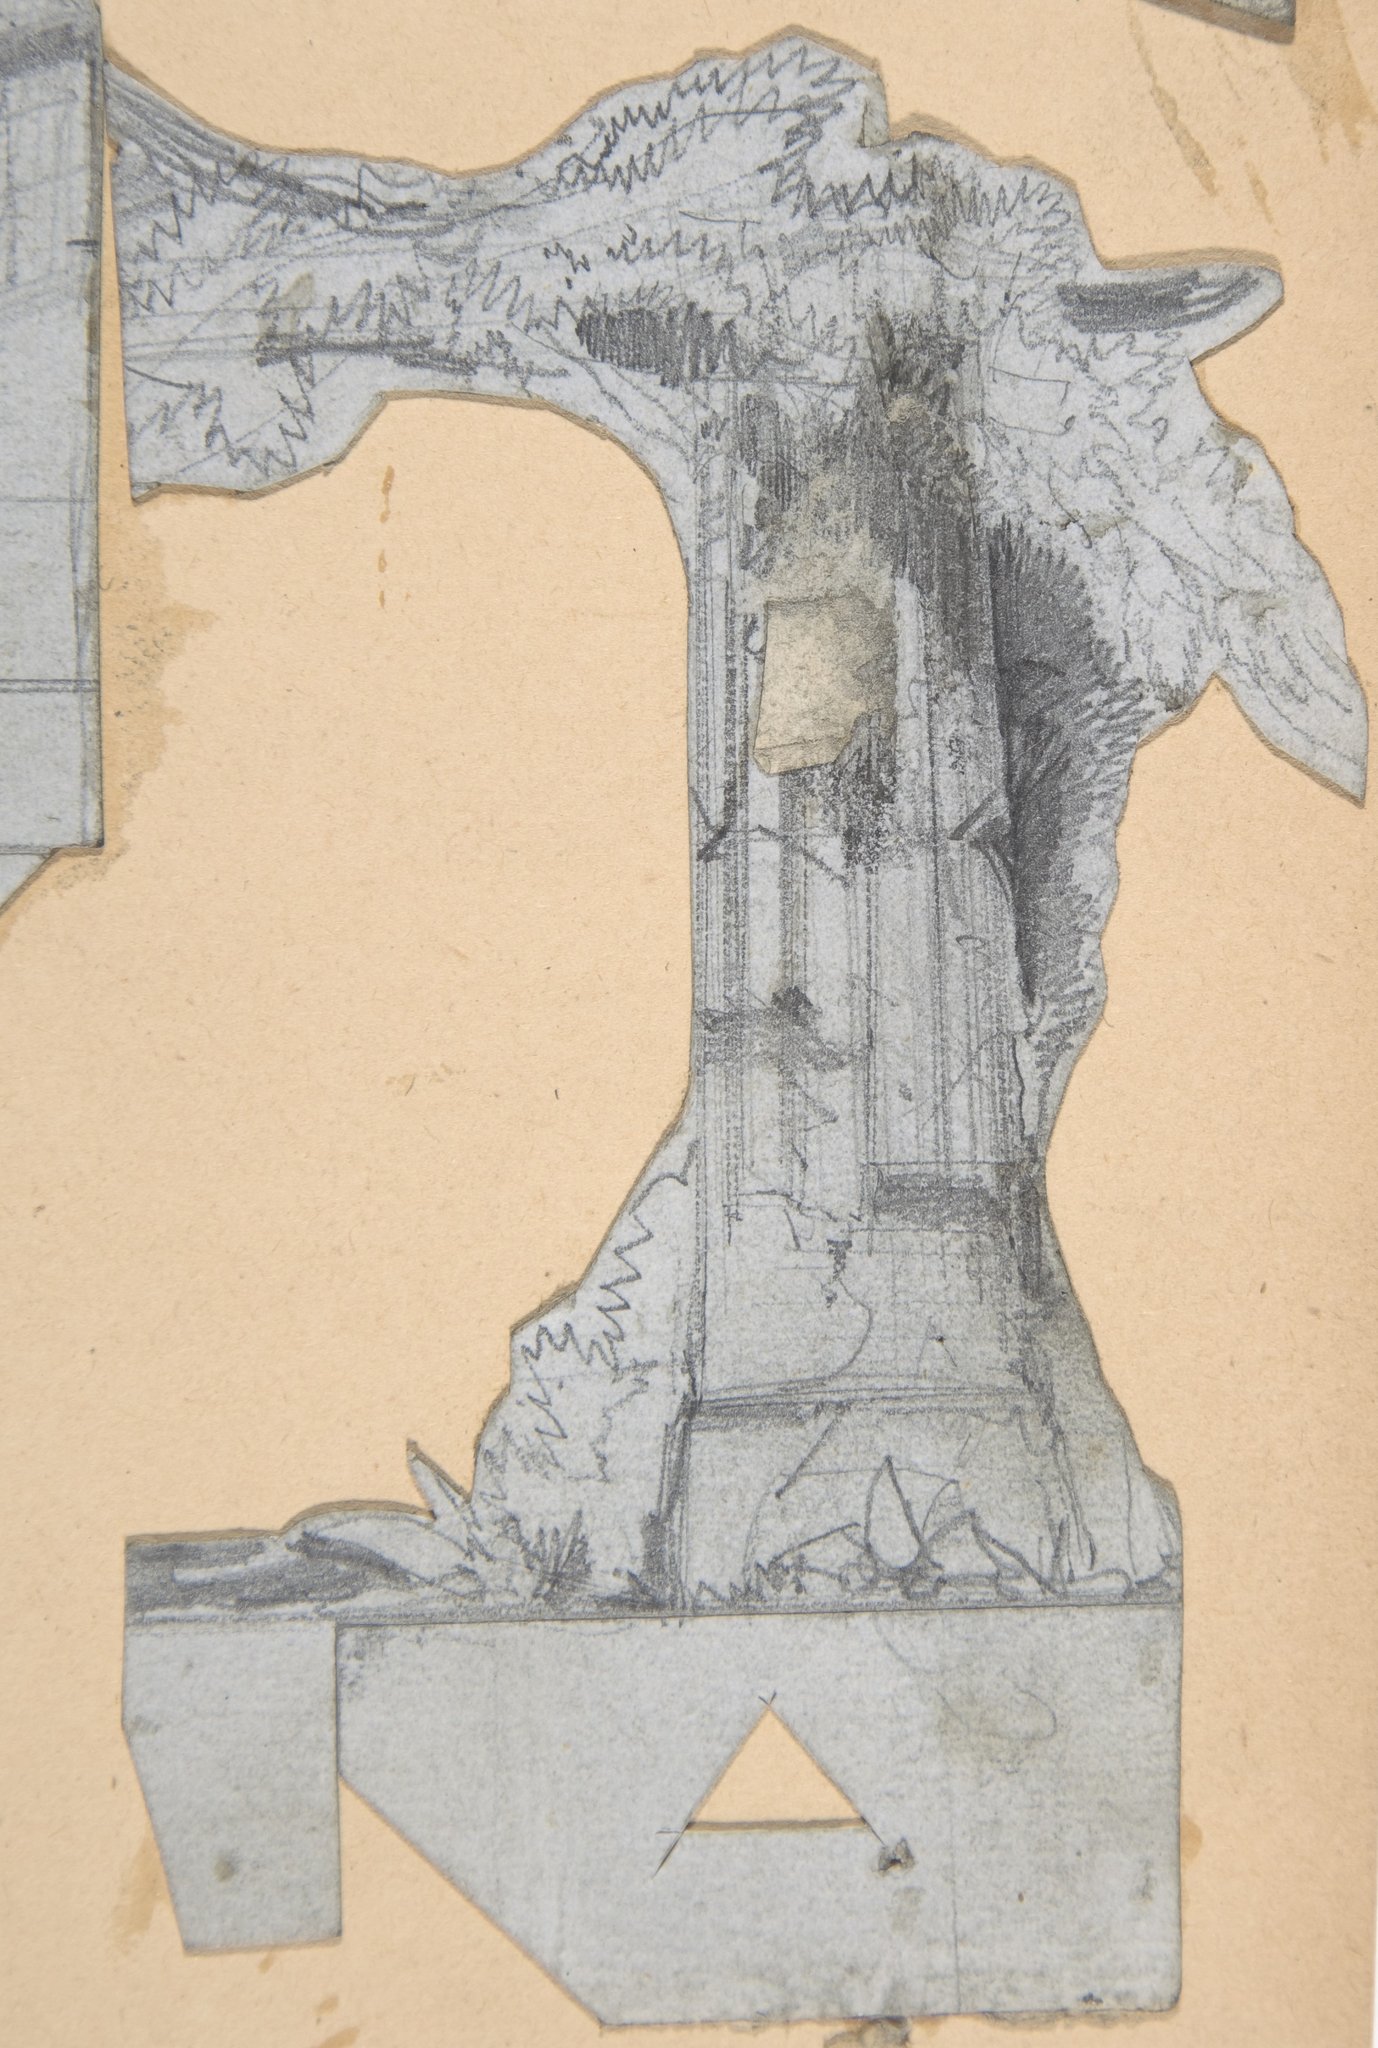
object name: drawing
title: Design for a Stage Set at the Opéra, Paris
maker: eugène cicéri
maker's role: artist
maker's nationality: french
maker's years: 1813-1890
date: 1830-1890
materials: graphite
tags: stage design